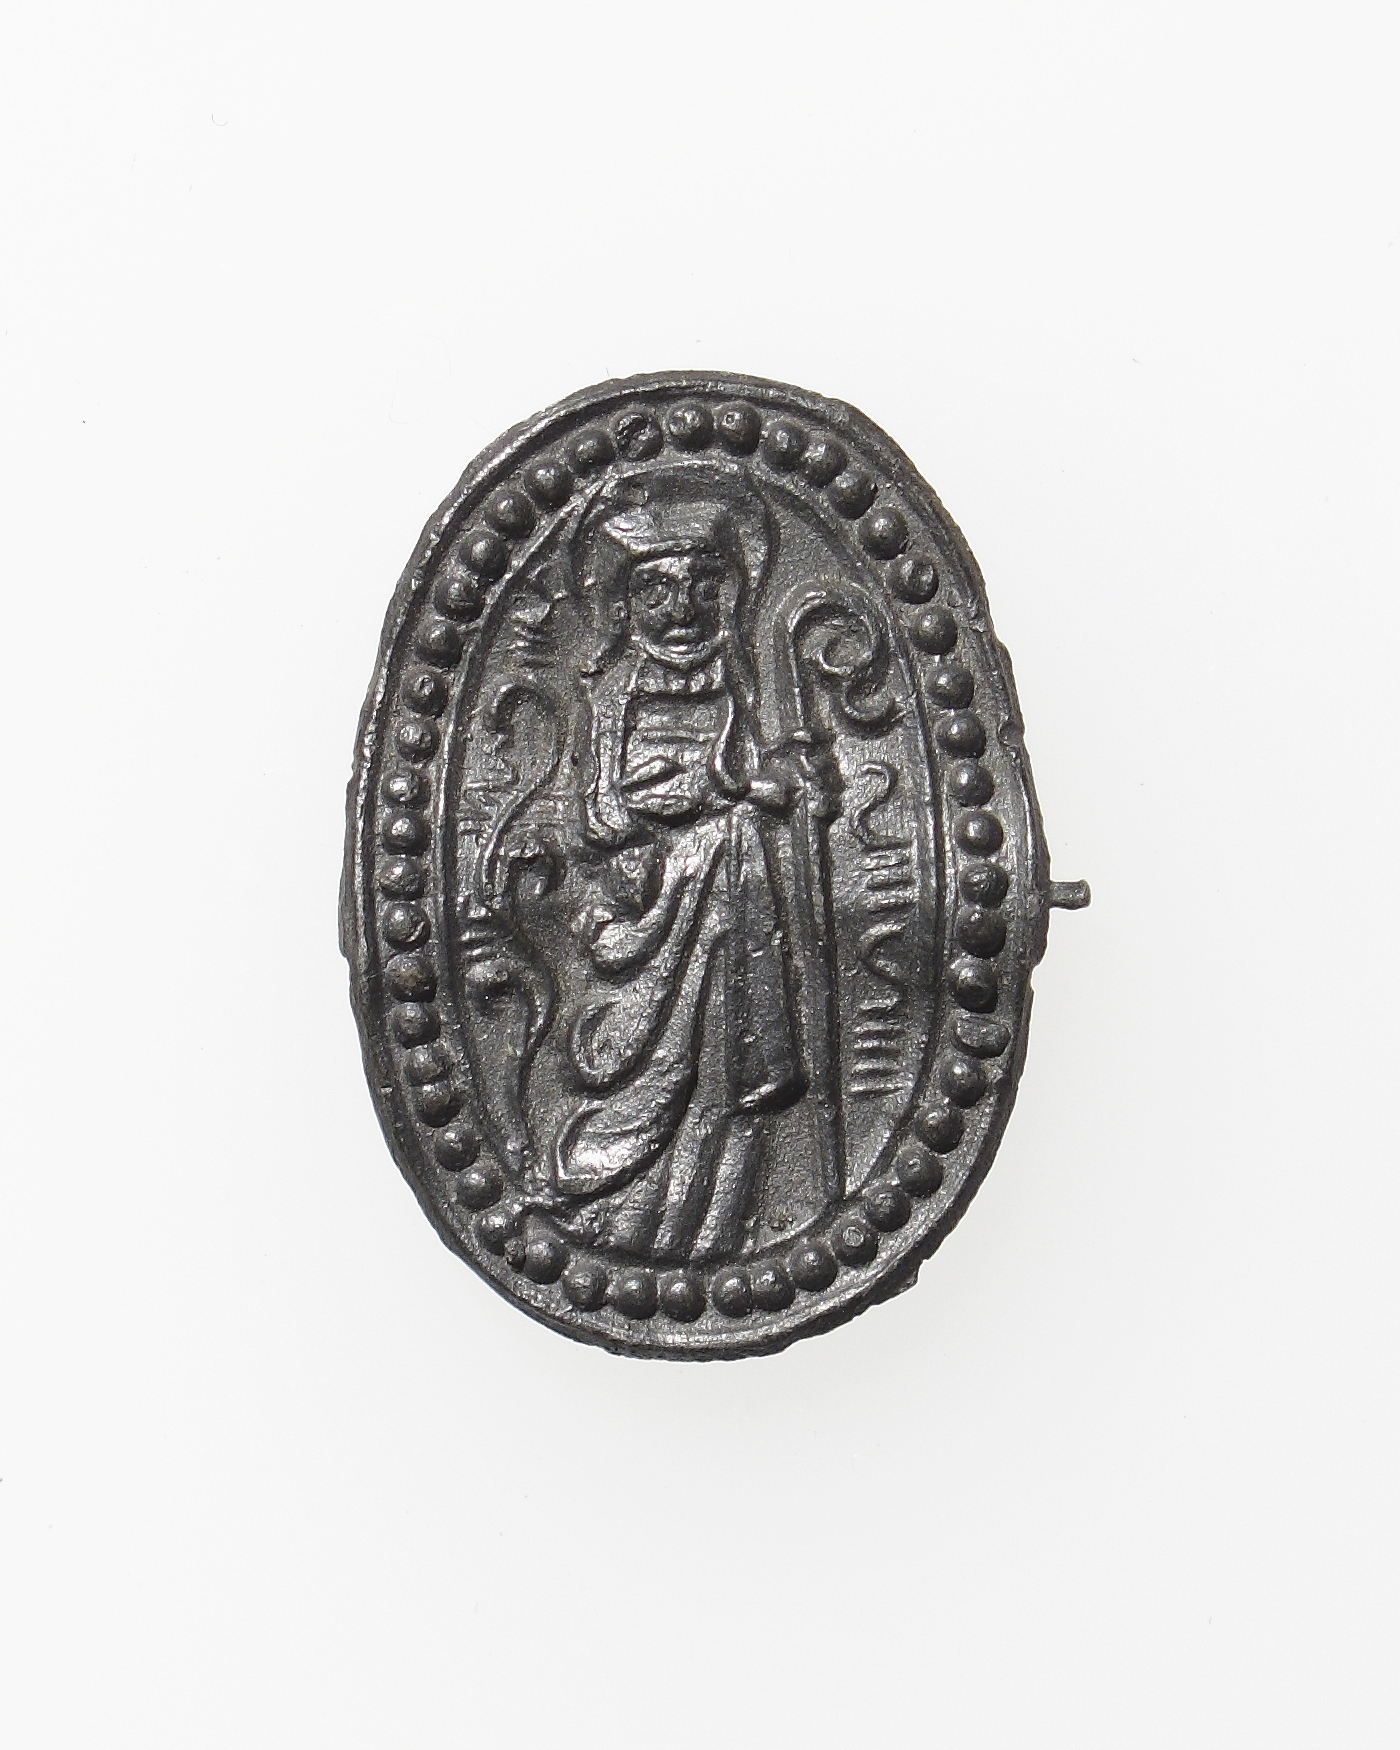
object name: pilgrim's badge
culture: french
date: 1301-1600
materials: lead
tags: women,saints